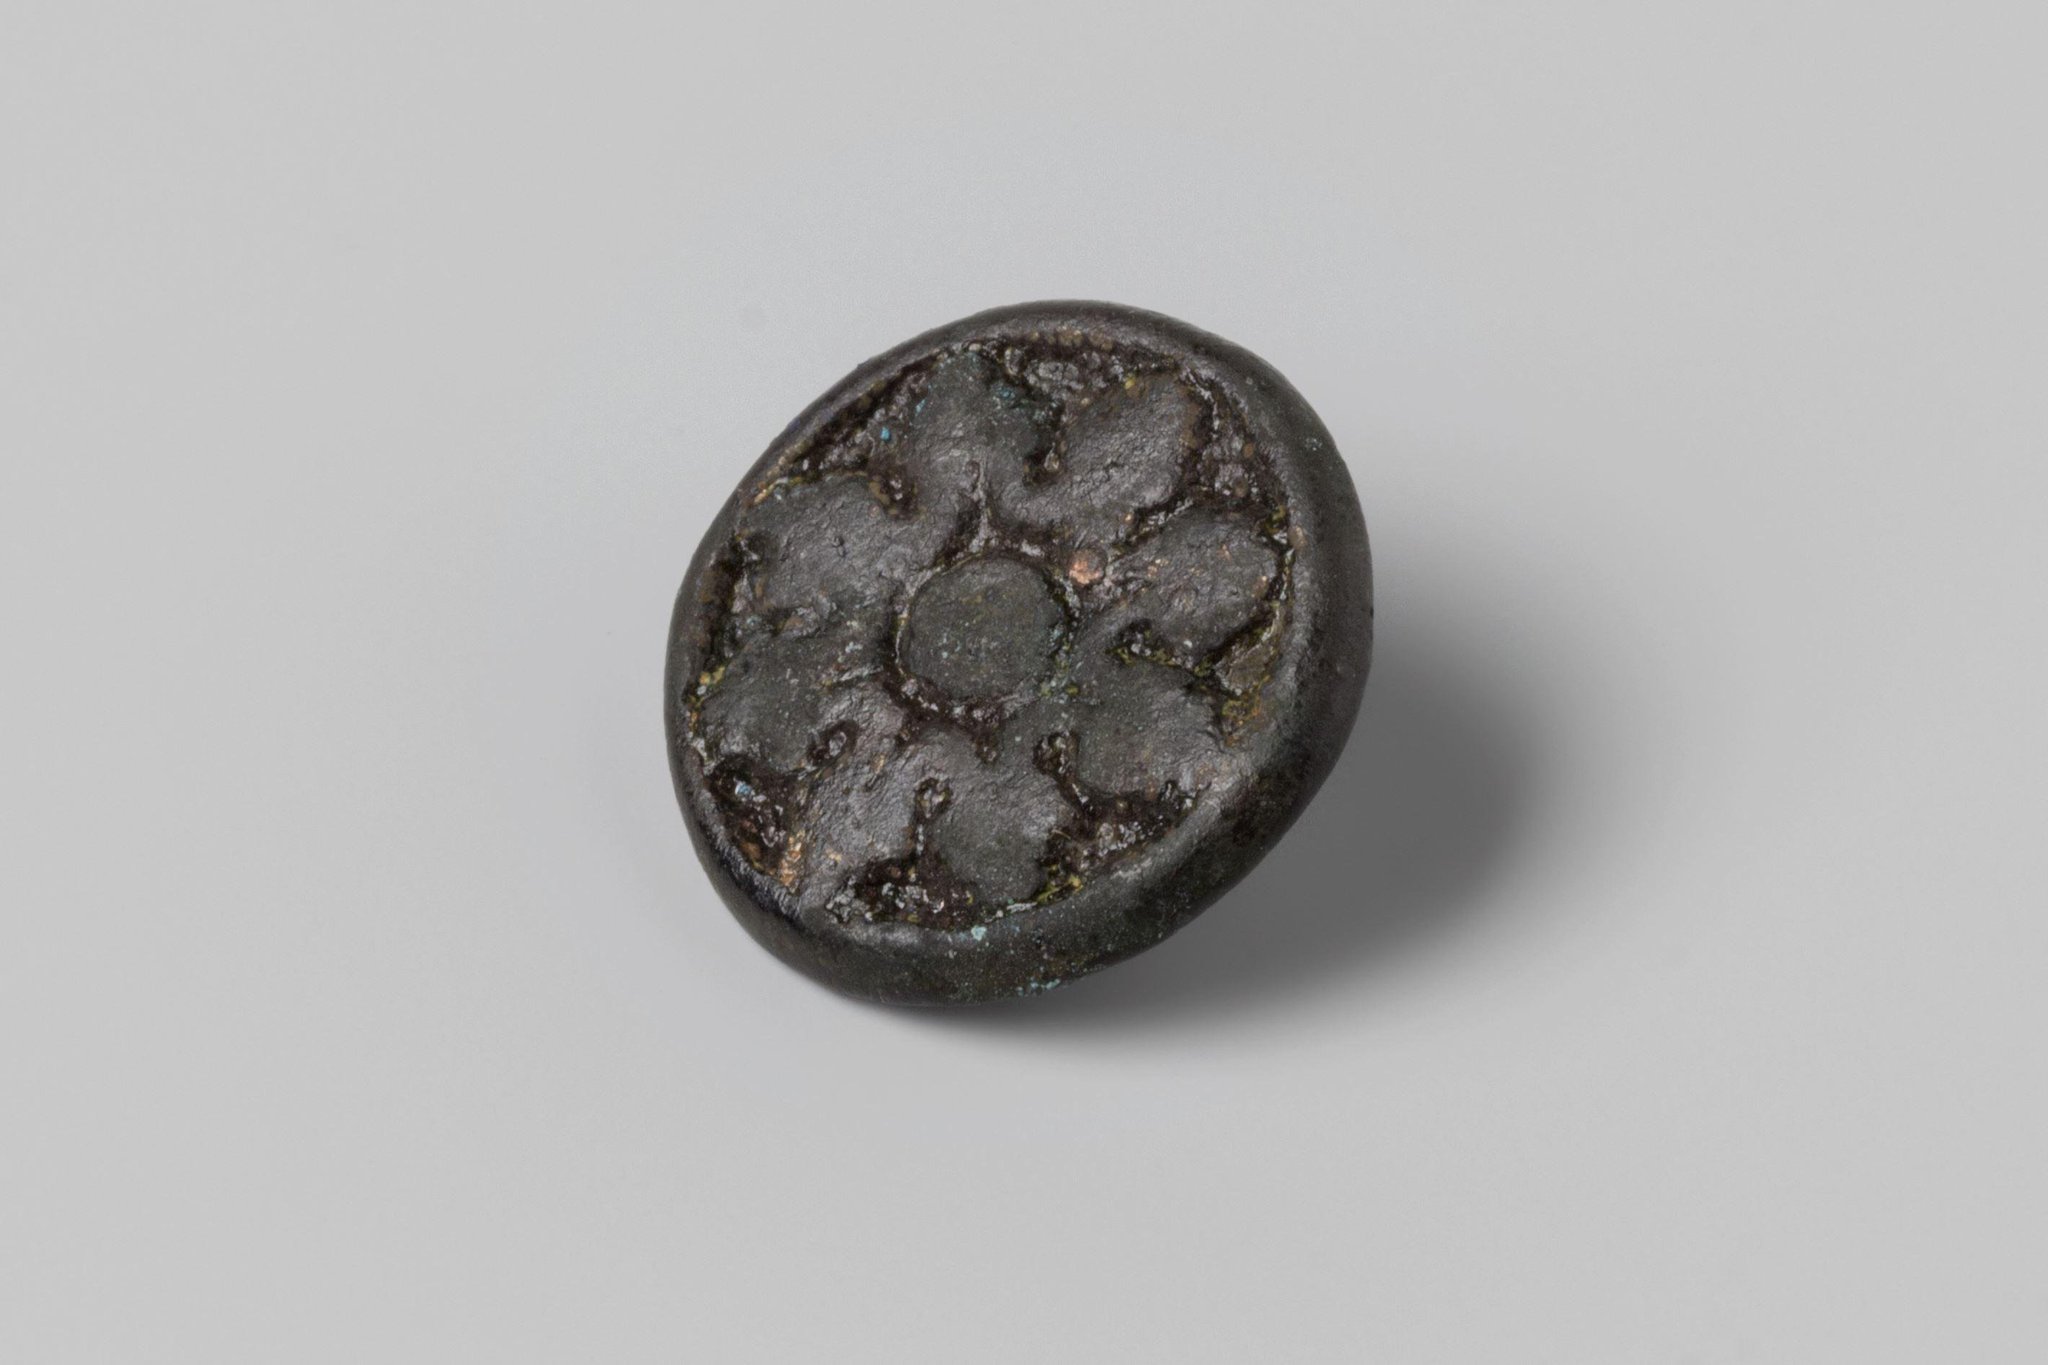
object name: button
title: Knoop uit het wrak van de Oost-Indiëvaarder Hollandia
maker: Anonymous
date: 1700-1743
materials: copper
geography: netherlands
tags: verenigde oostindische compagnie, hollandia (schip), annet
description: Knoop. (1) flat, relieved decoration, flower-head motif (1.5d, 0.2t), key-shank broken